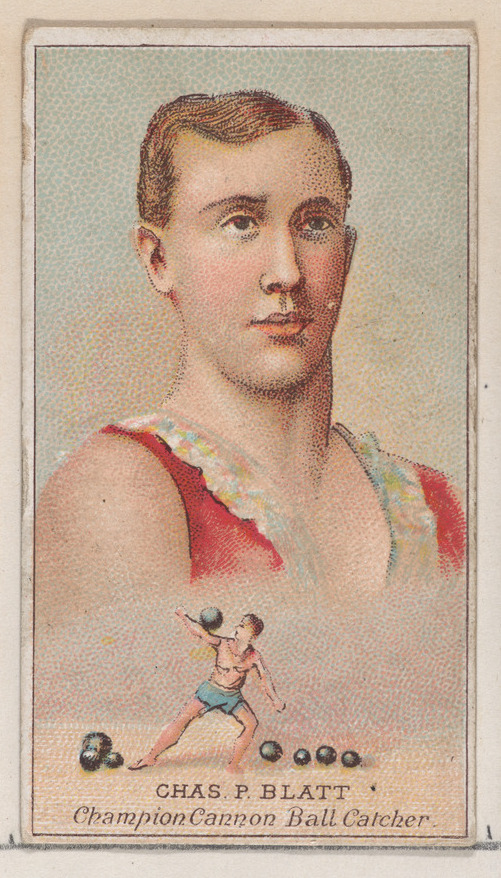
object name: print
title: Charles P. Blatt, Champion Cannonball Catcher, from the Champions of Games and Sports series (N184, Type 2) issued by W.S. Kimball & Co.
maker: w.s. kimball & co.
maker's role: publisher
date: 1887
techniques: color lithograph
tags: men,sports,athletes